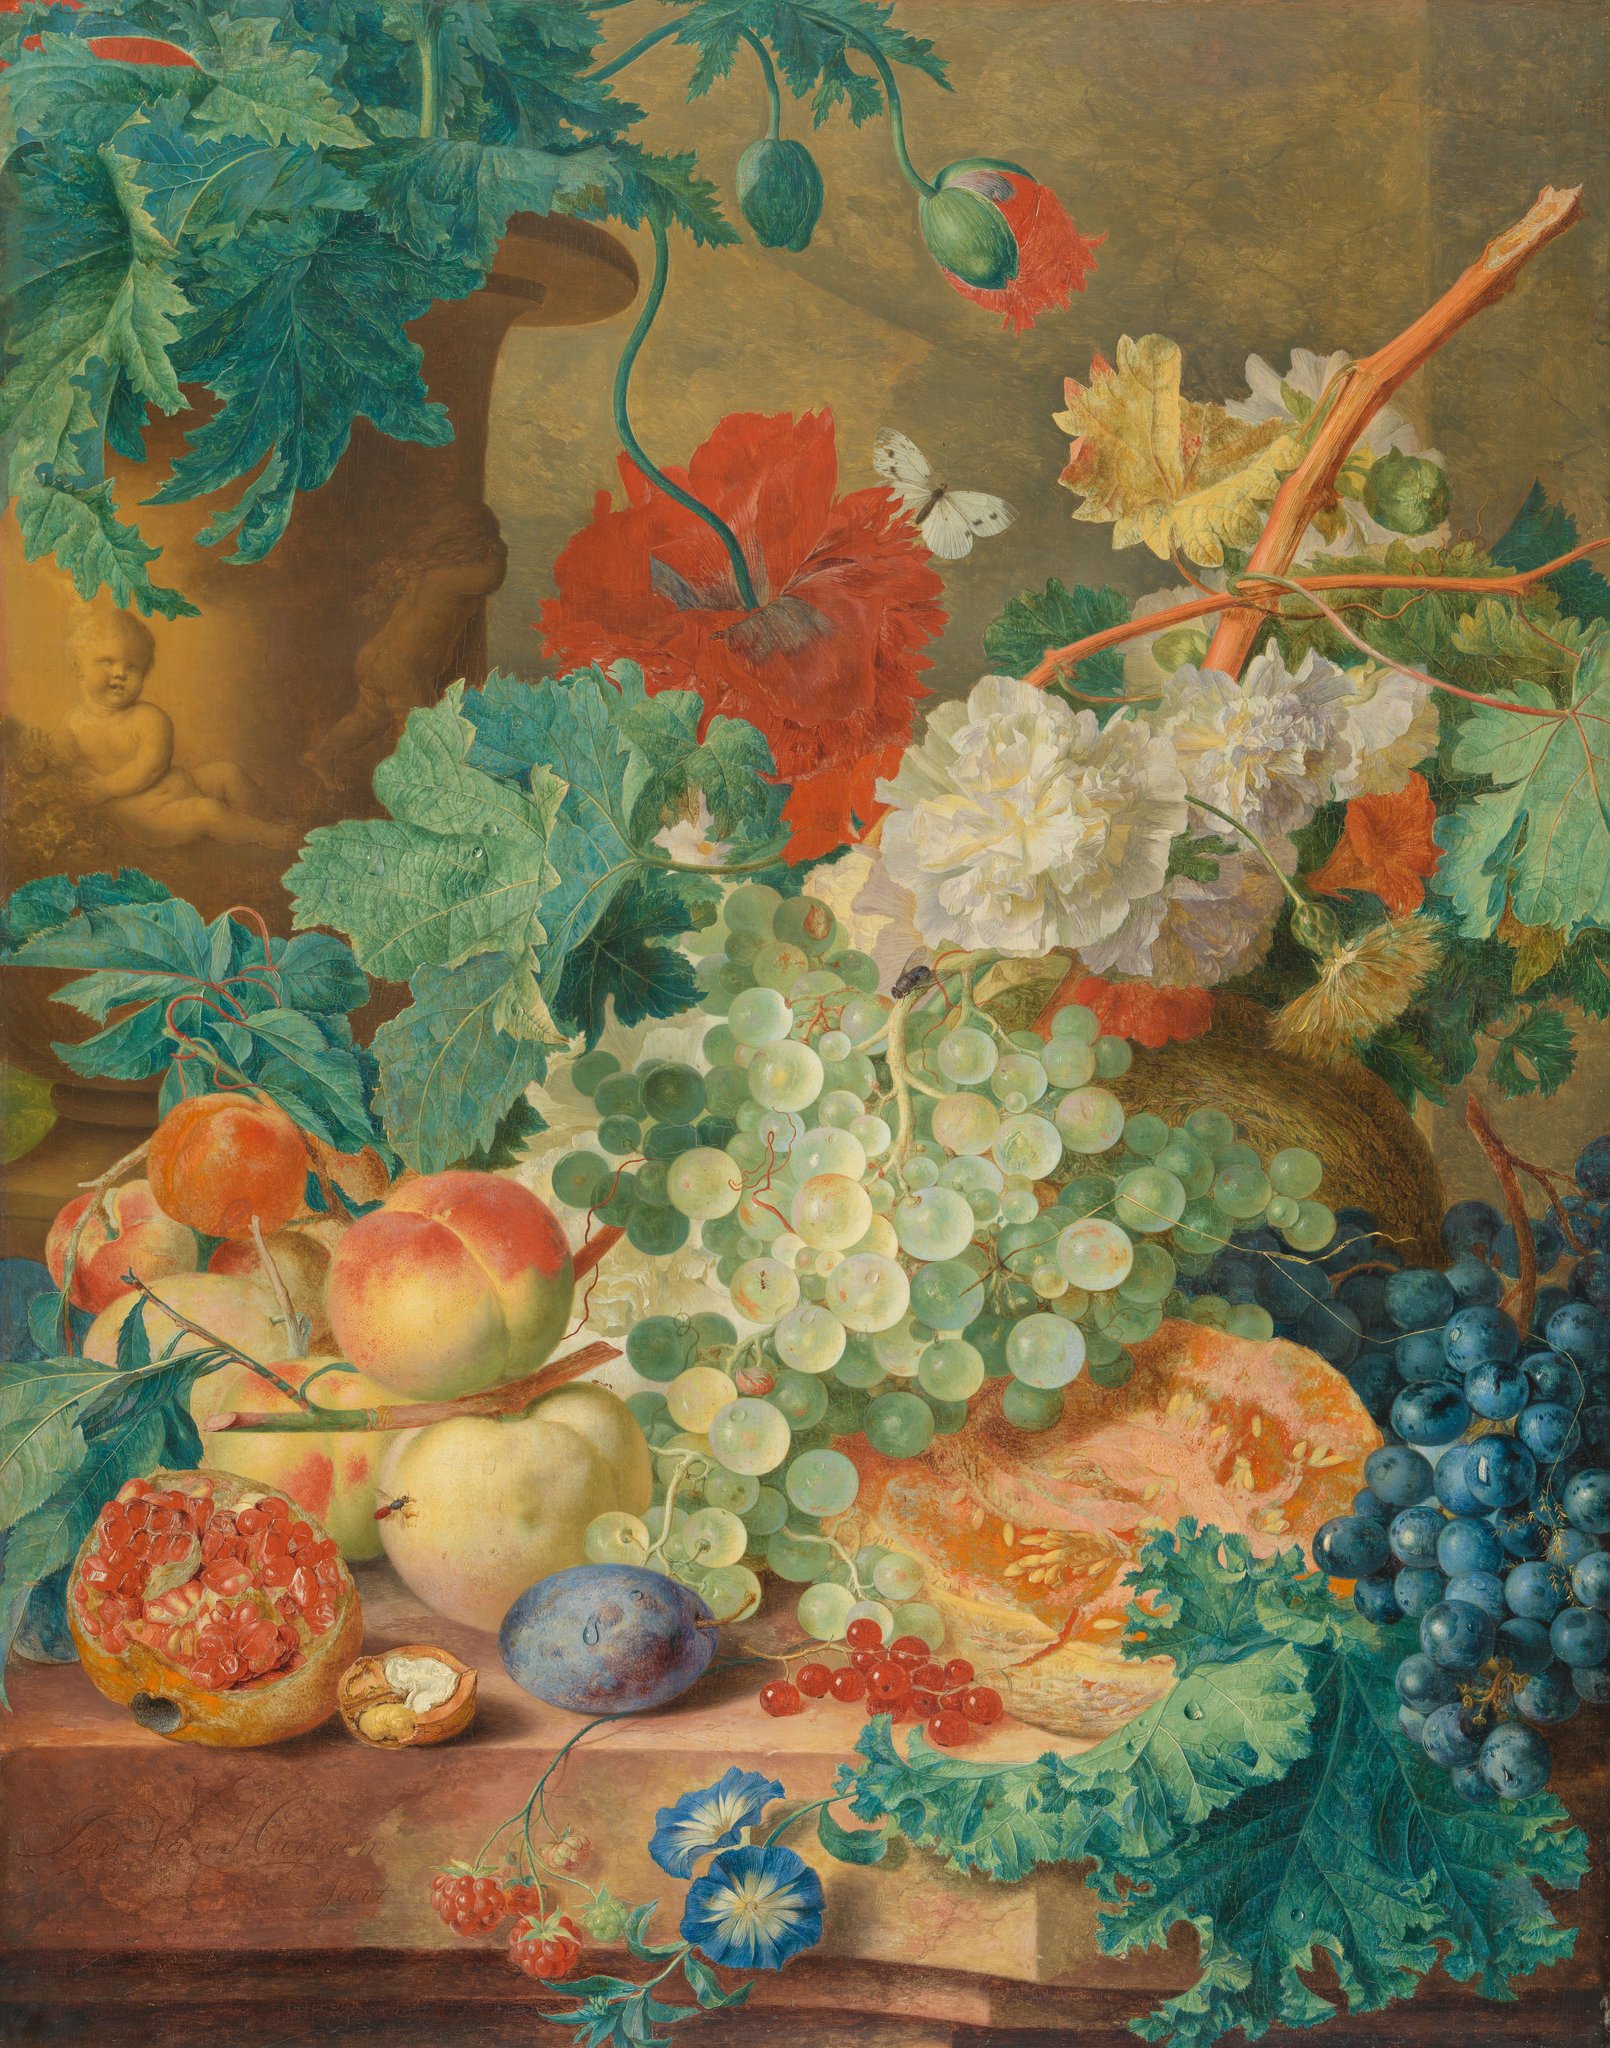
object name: painting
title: Still Life with Flowers and Fruit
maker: jan van huysum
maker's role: draughtsman, painter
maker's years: 1682-1749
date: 1728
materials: oil, panel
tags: still life of plants, flowers and fruit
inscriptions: signature: ‘Jan Van Huysum fecit’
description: As his career progressed, Van Huysum produced floral still lifes that were increasingly exuberant. His palette became lighter and more transparent and he set his still lifes against a park-like background. Here the fruit, grapevine and hollyhocks are arranged so loosely and precariously that they risk tumbling from the marble plinth.